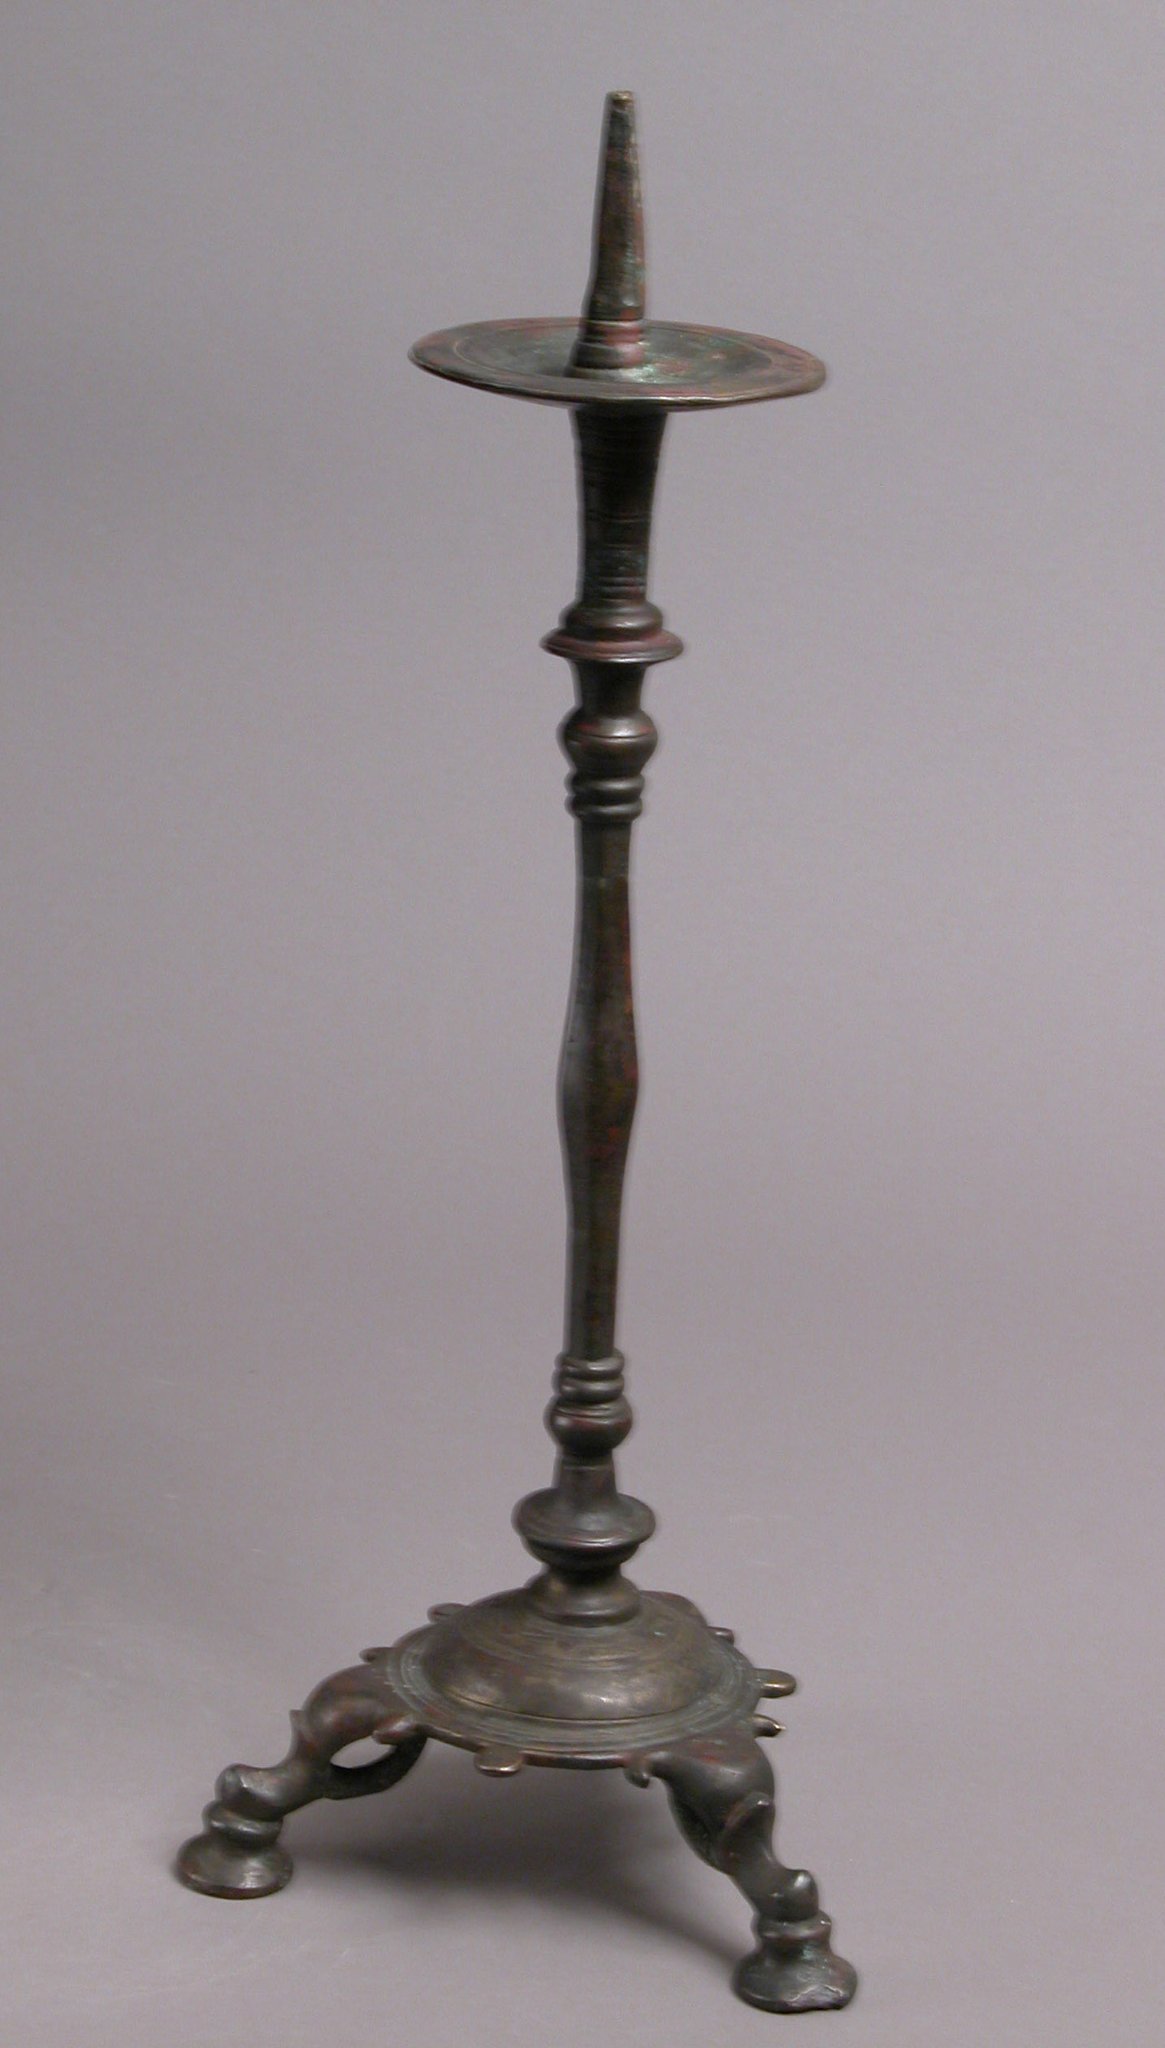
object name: lamp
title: Lamp stand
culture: byzantine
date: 501-600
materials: bronze